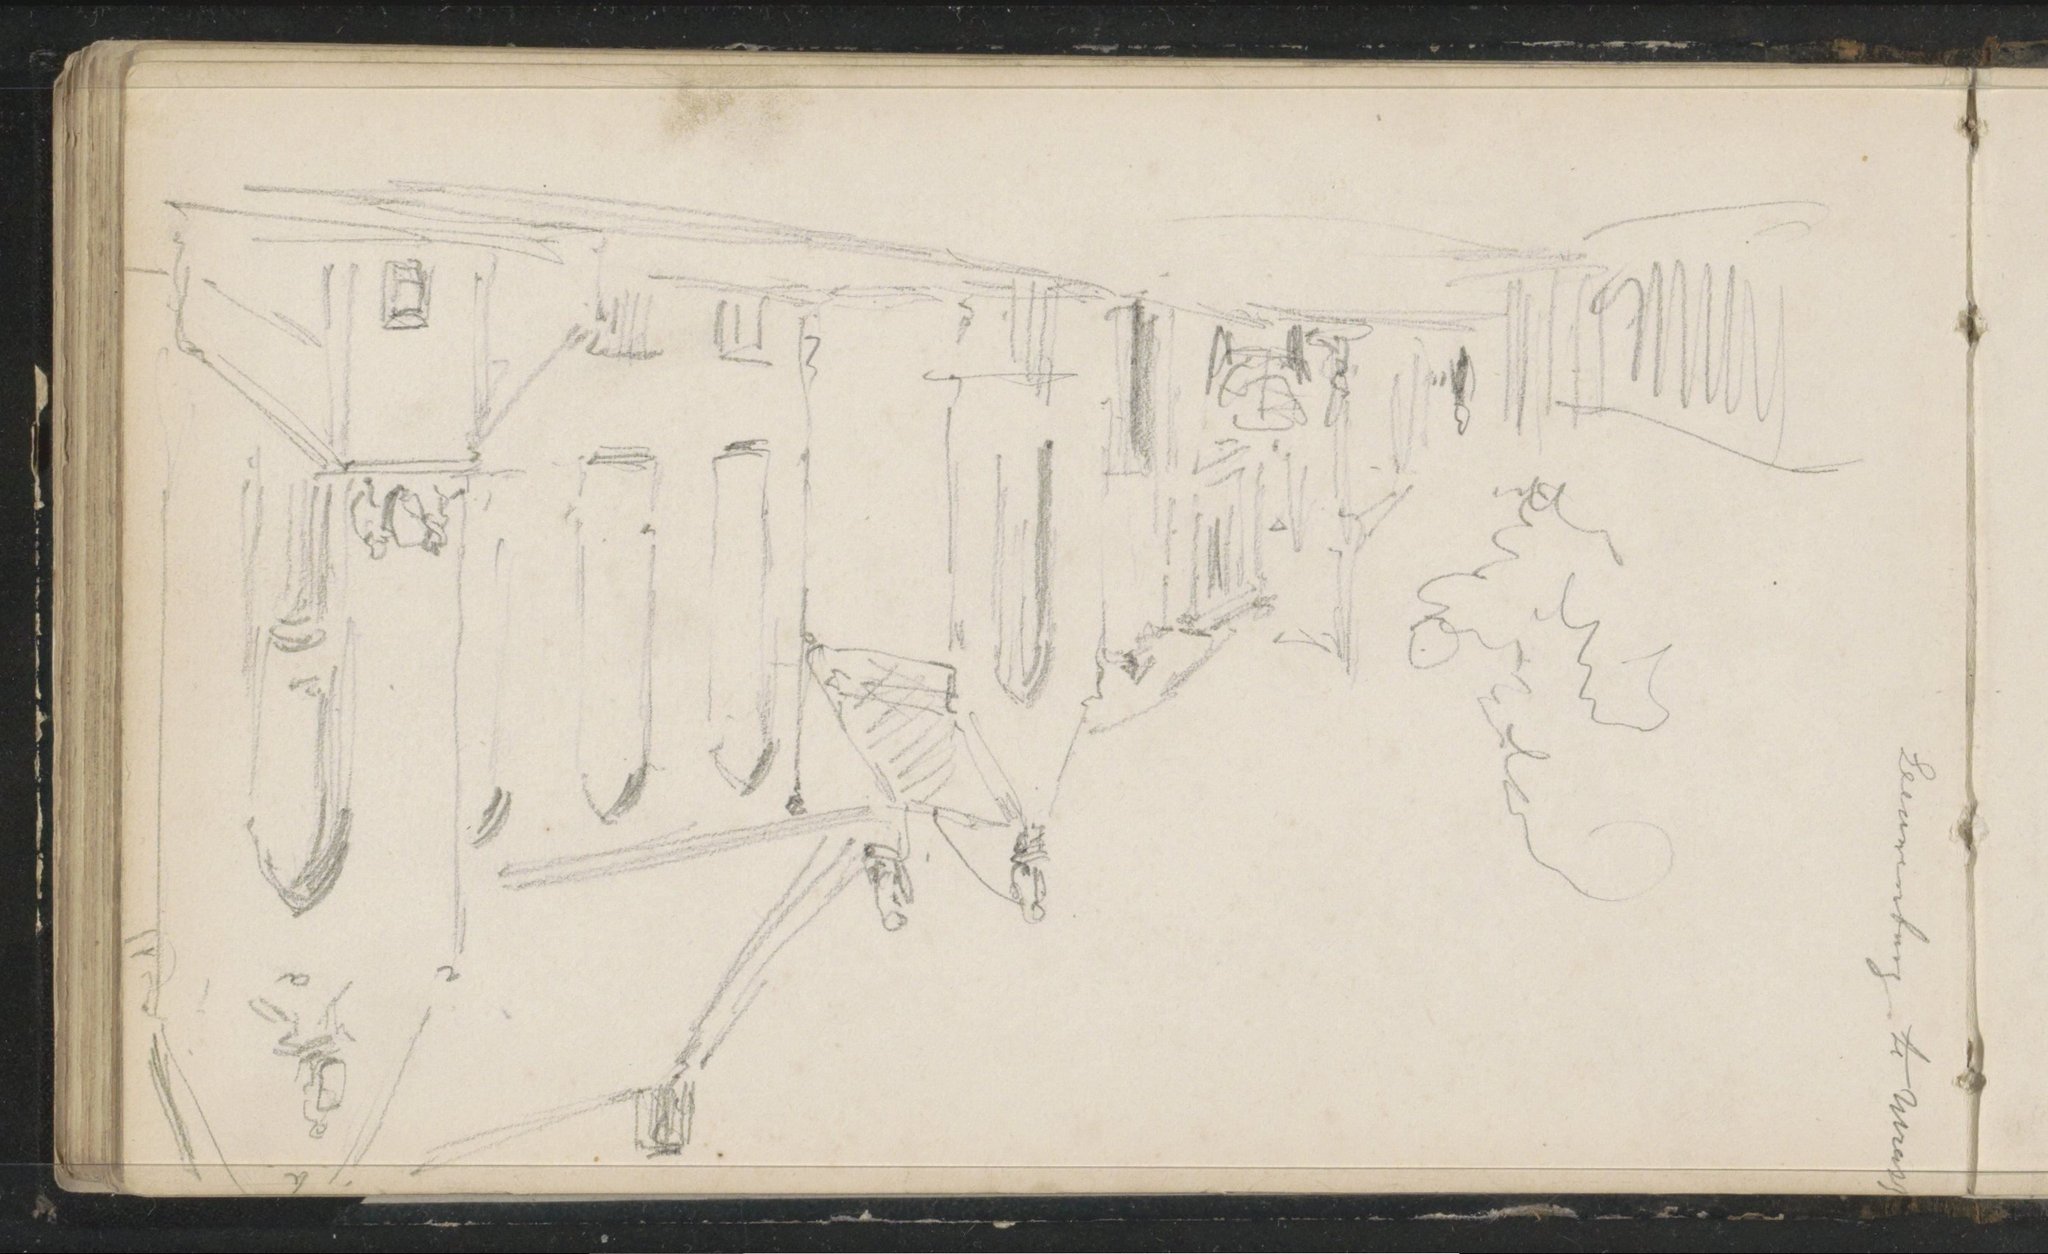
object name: sketchbook leaf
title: Gezicht op het Leeuwenbergh te Utrecht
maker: cornelis springer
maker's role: draughtsman, painter, print maker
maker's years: 1817-1891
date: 1856-1861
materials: paper, pencil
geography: utrecht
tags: urban housing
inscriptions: annotation: ‘Leeuwenburg te Utrecht’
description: Gezicht op het Leeuwenbergh te Utrecht. Blad 43 verso uit een schetsboek met 44 bladen vervaardigd in Zeeland en Utrecht.